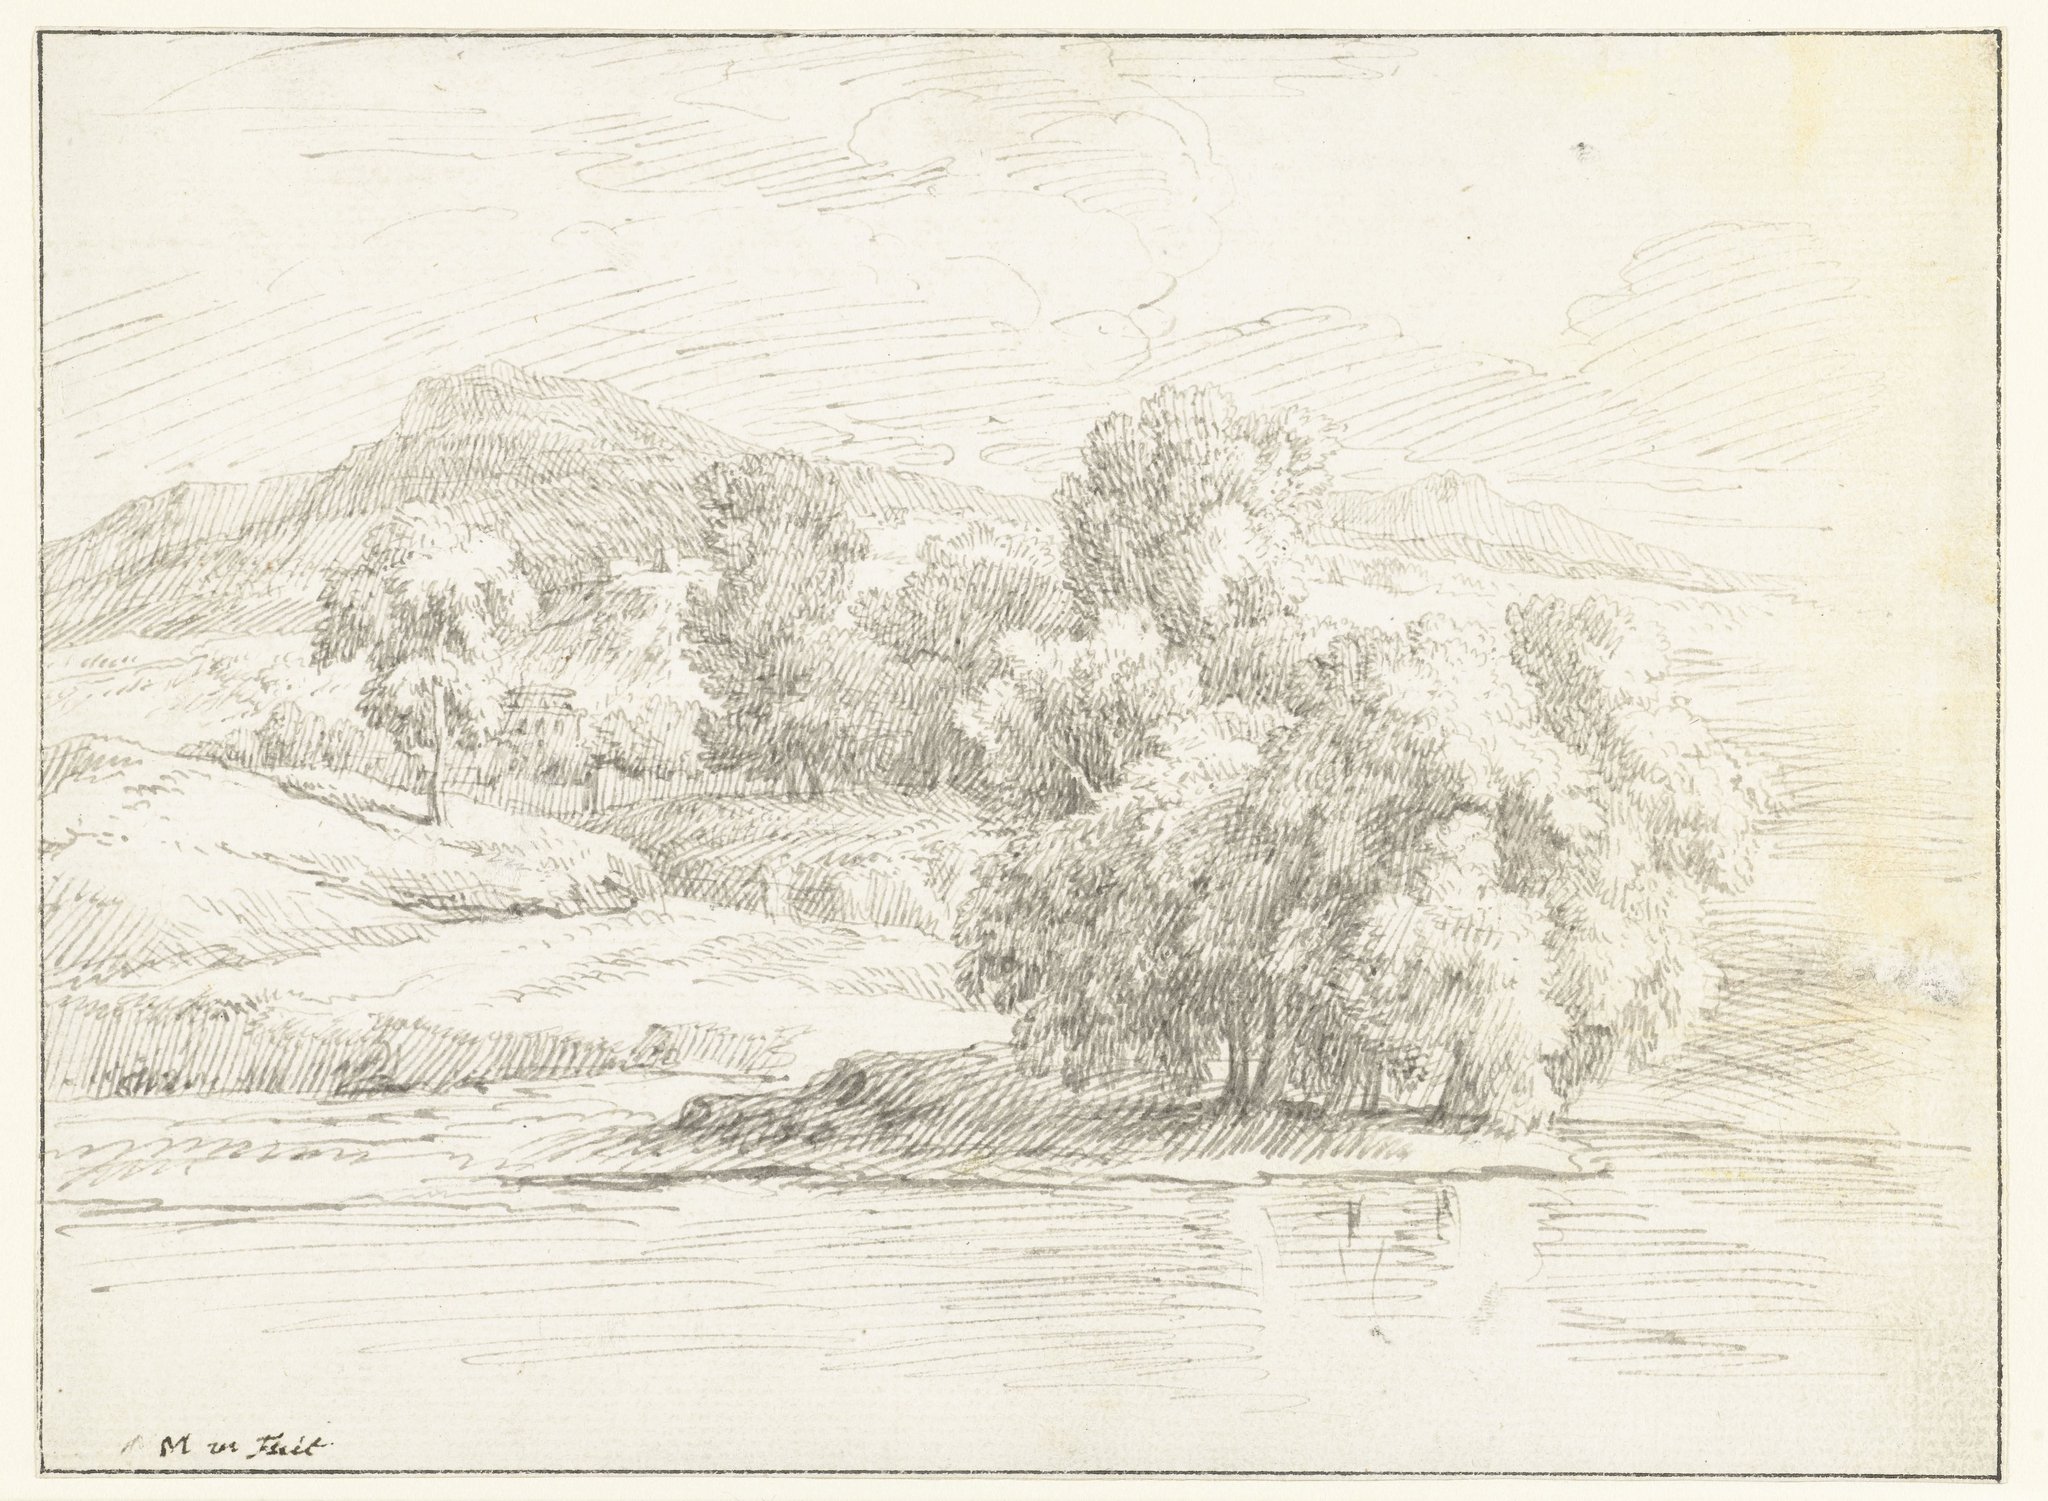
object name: drawing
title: Heuvellandschap aan de oever van een breed water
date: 1655-1714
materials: ink, paper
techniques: pen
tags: river bank